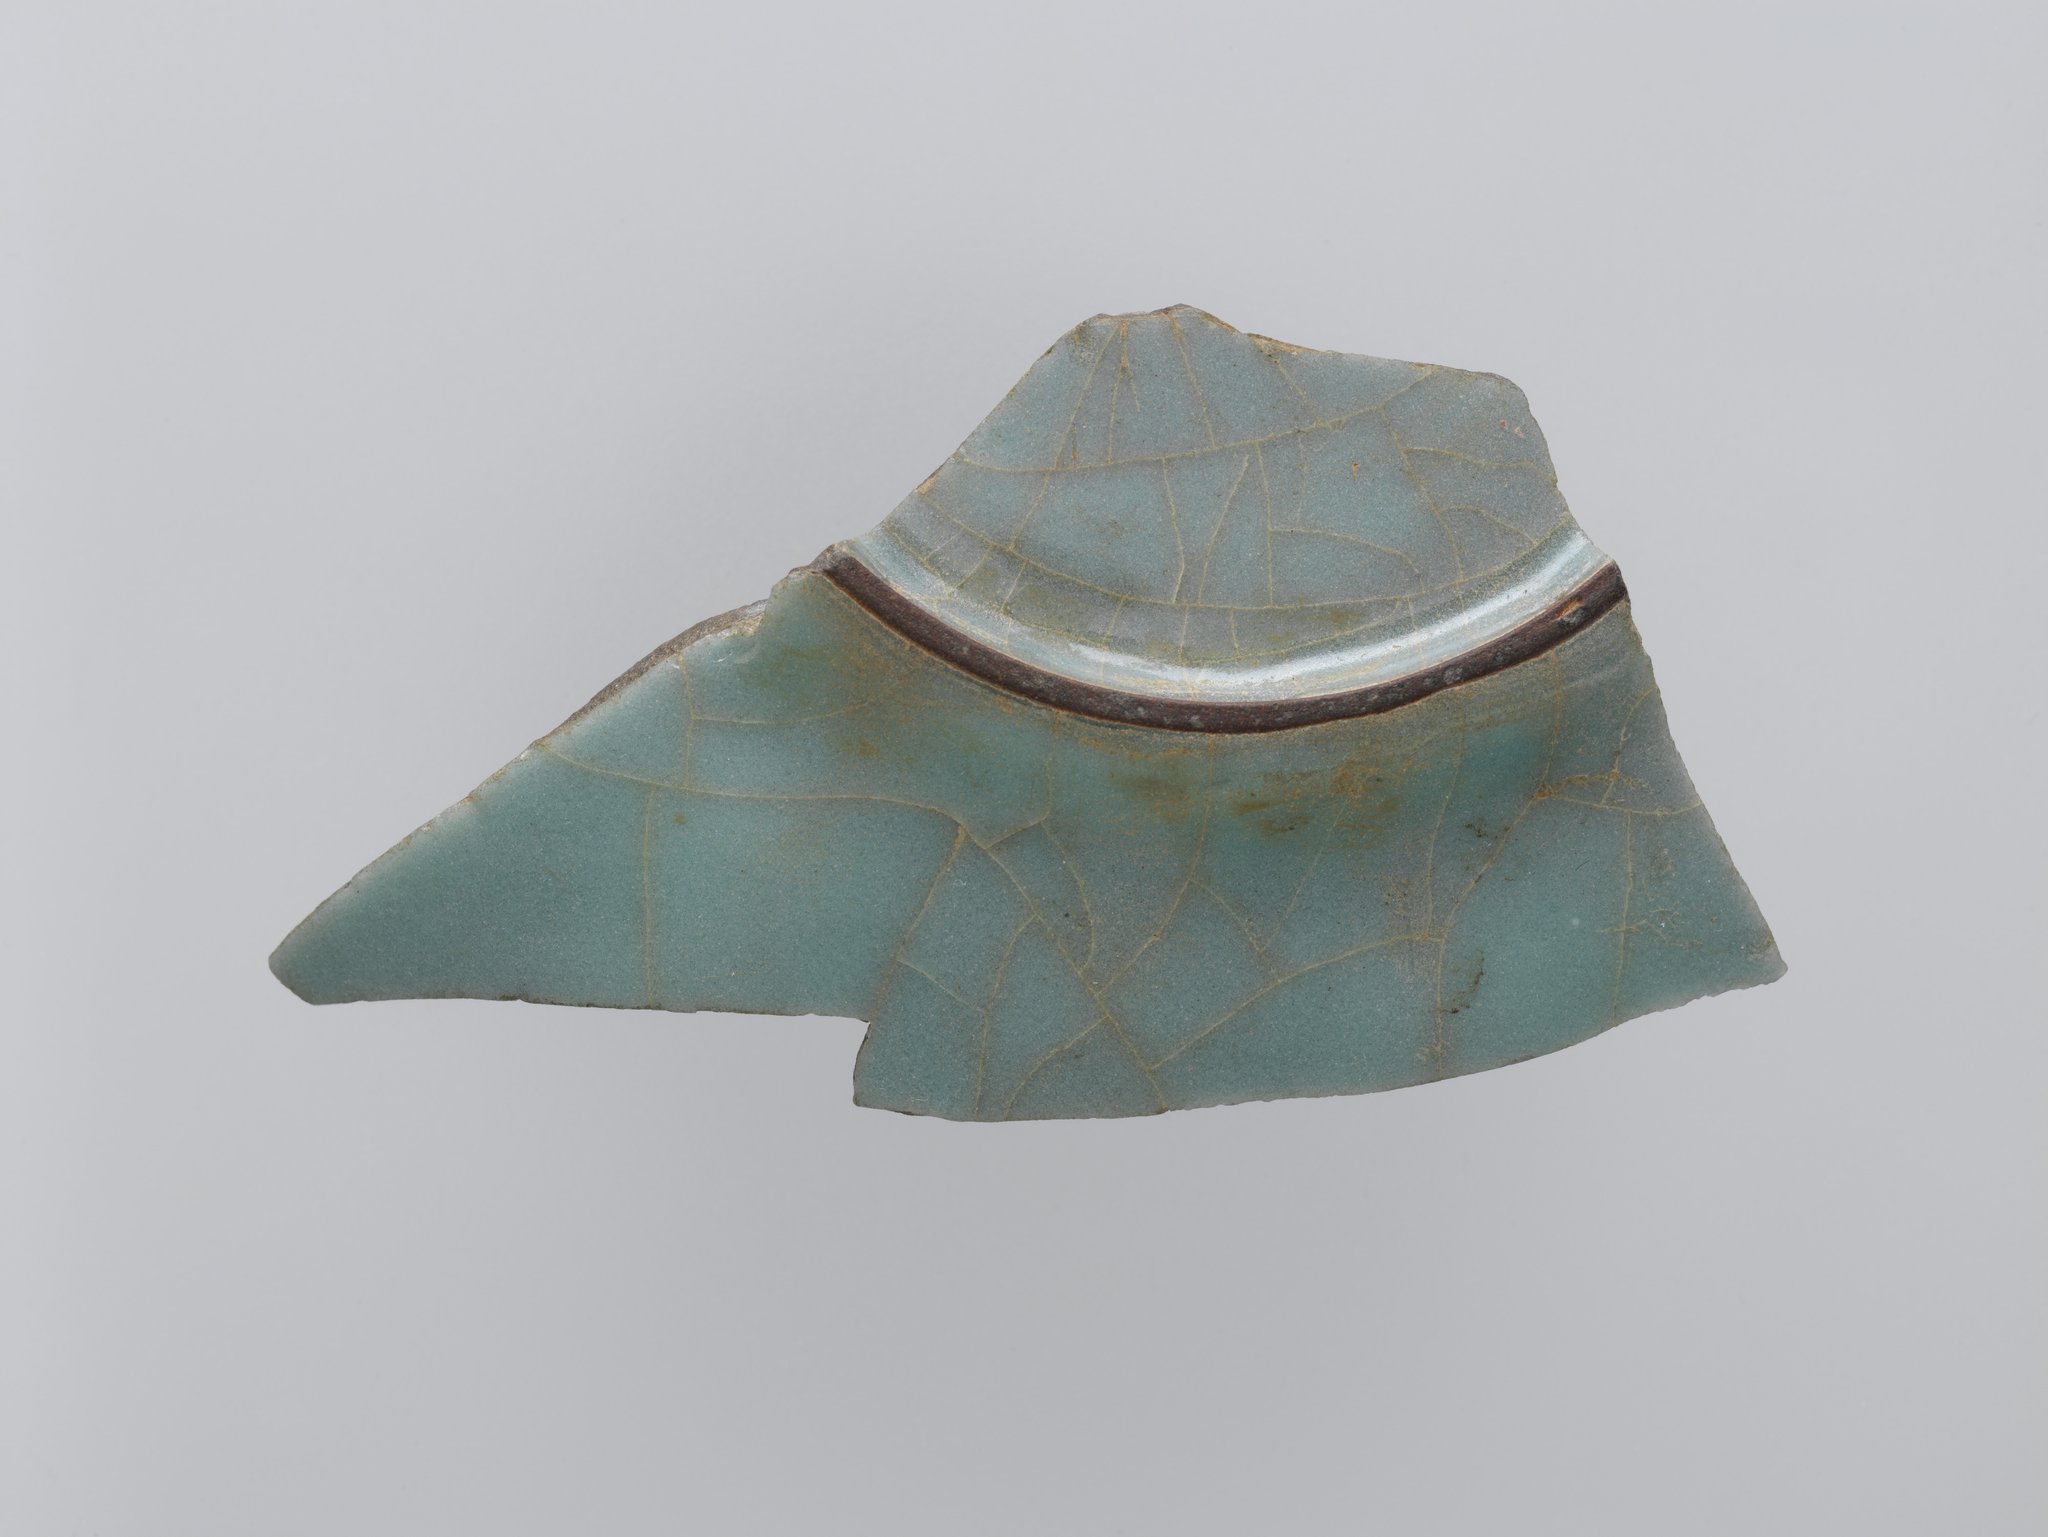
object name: sherd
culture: chinese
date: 960-1279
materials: stoneware